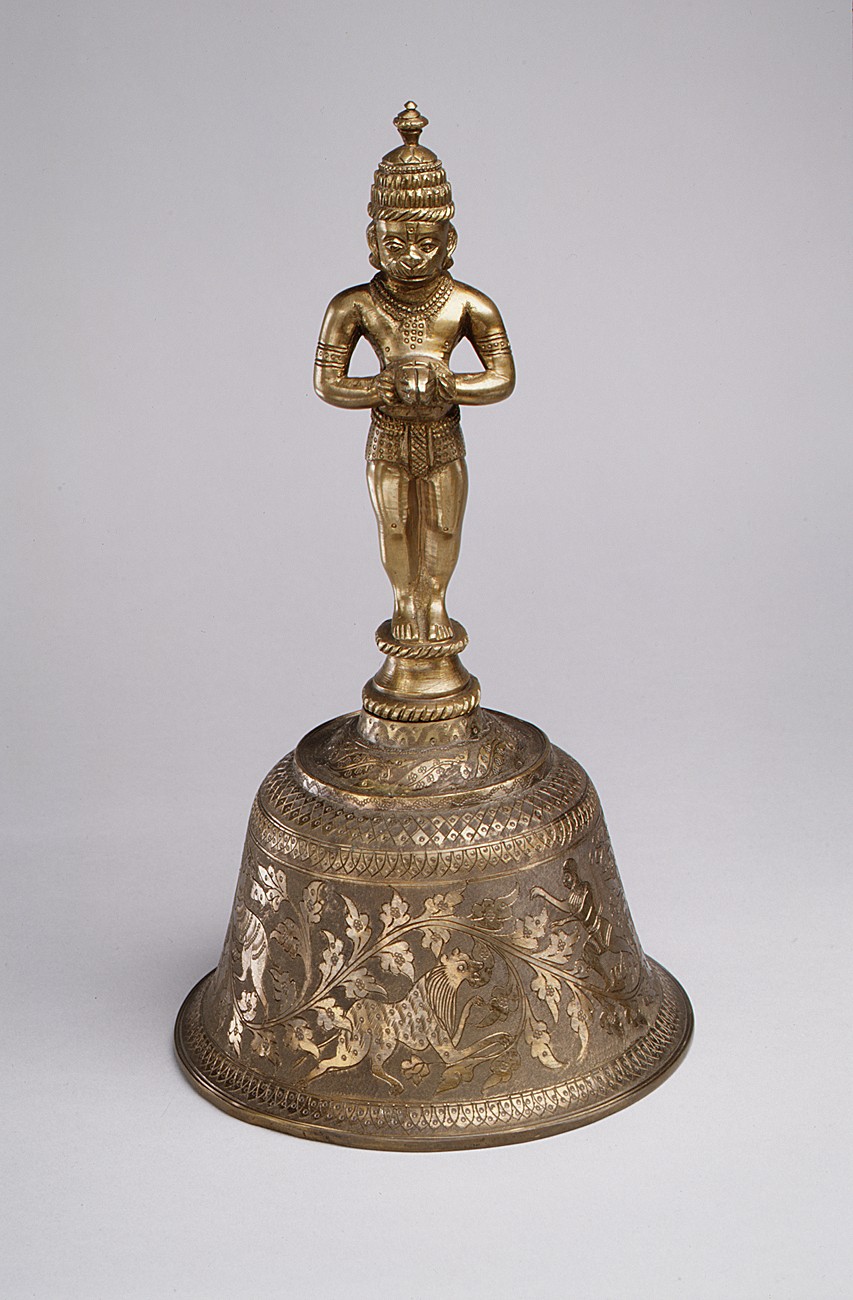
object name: ghanti bell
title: Ghanti (bell)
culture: indian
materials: brass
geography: india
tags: animals,monkeys